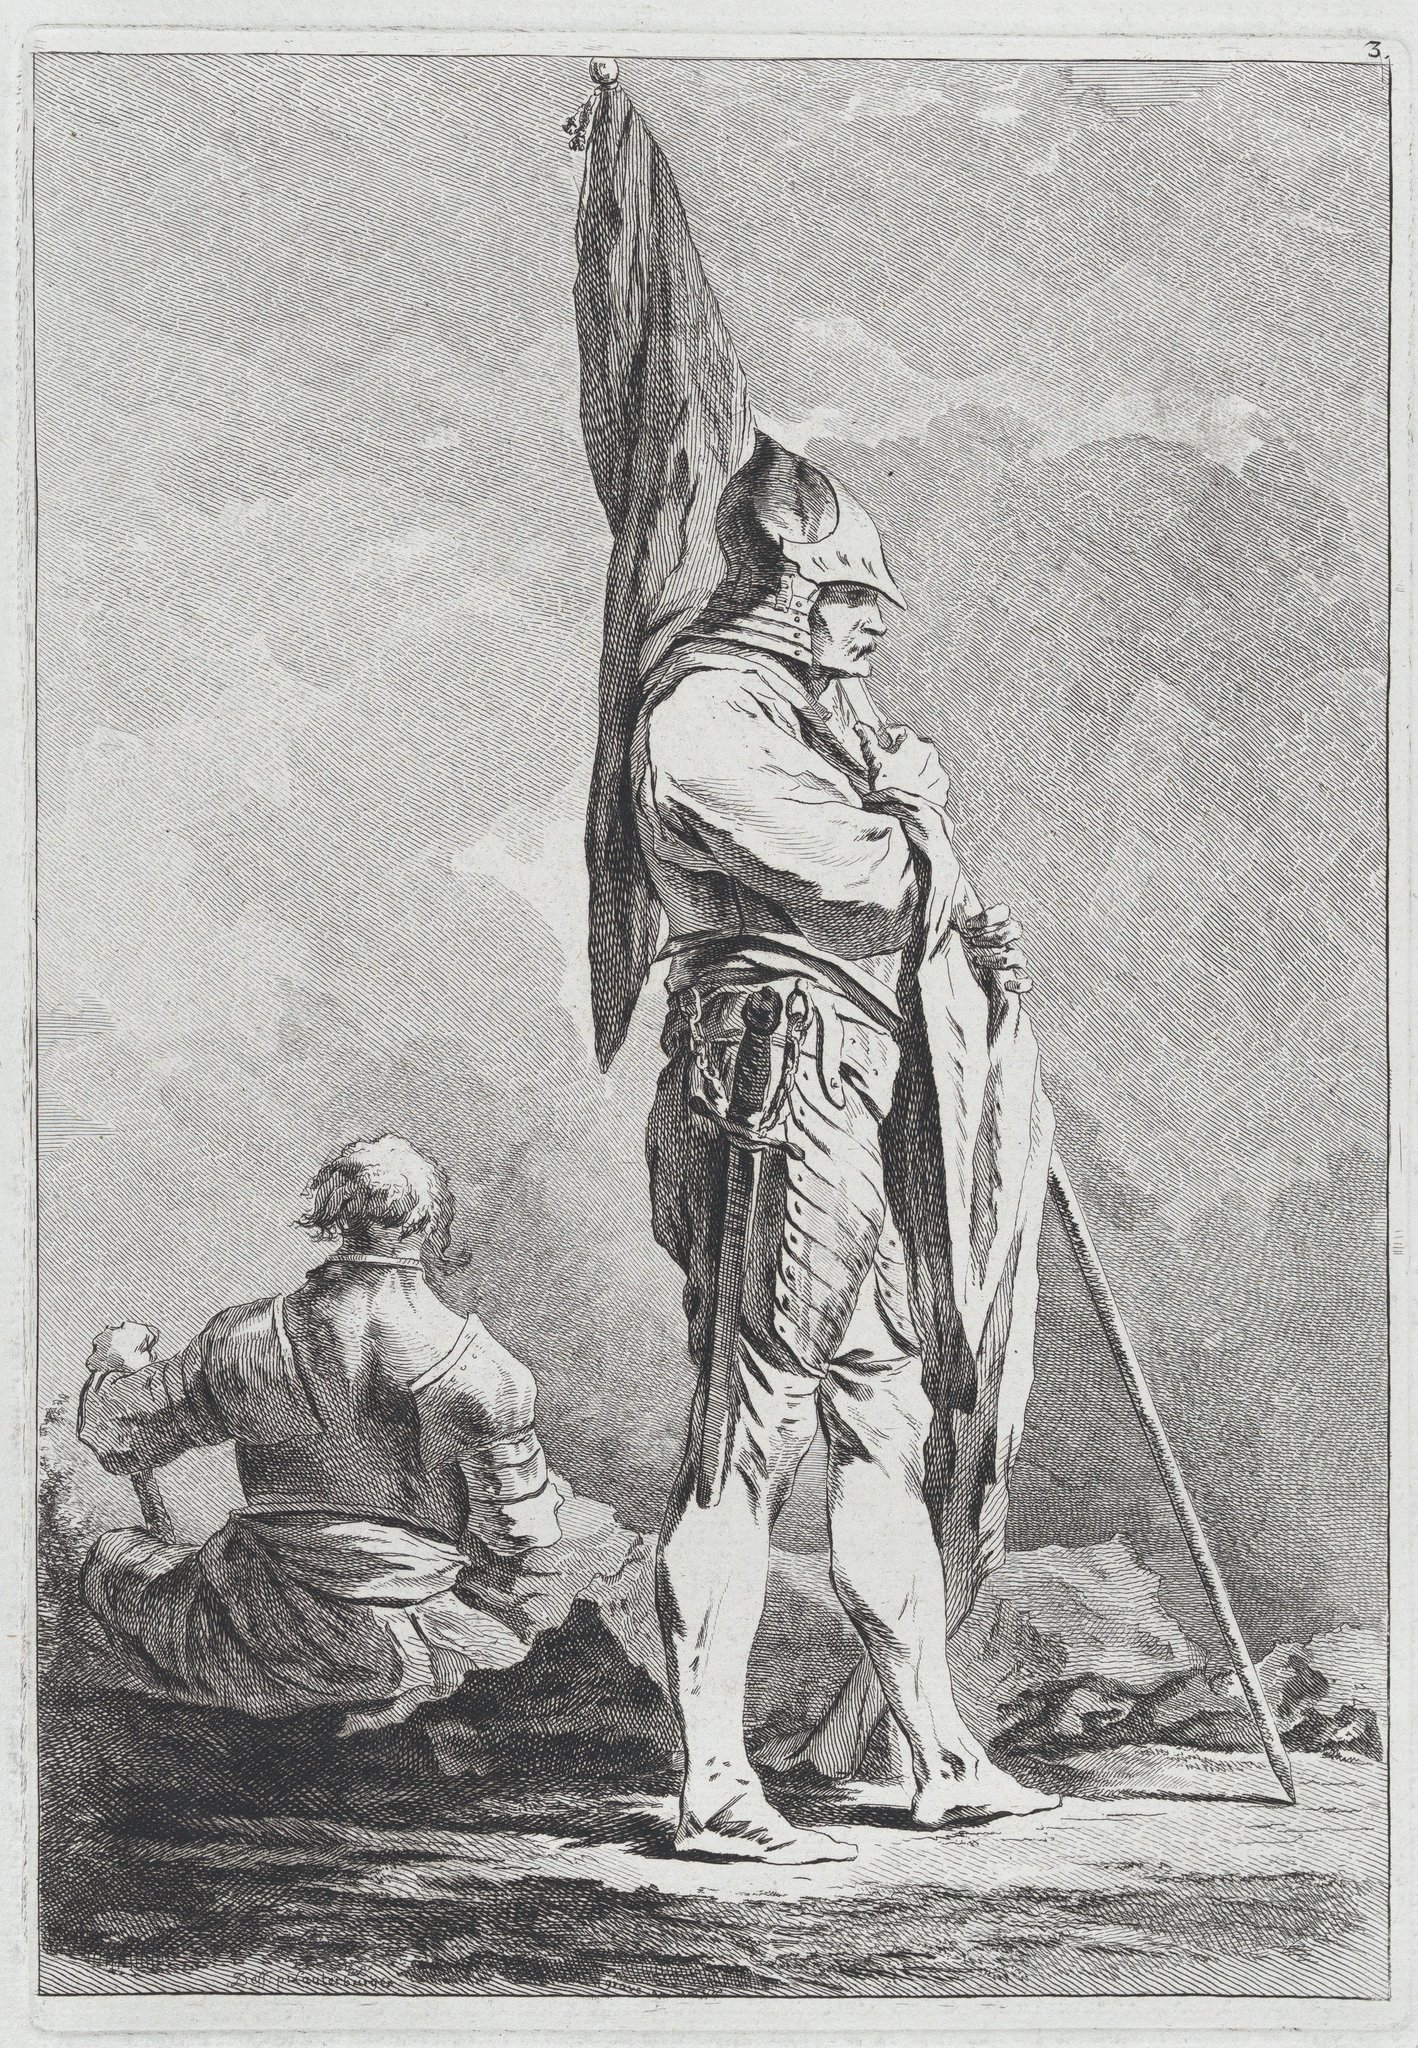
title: Two Soldiers, One Standing Holding a Flag, One Seated Seen from Behind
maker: matthias pfenninger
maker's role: etcher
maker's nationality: swiss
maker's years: 1739-1813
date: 1764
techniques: etching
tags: soldiers,men